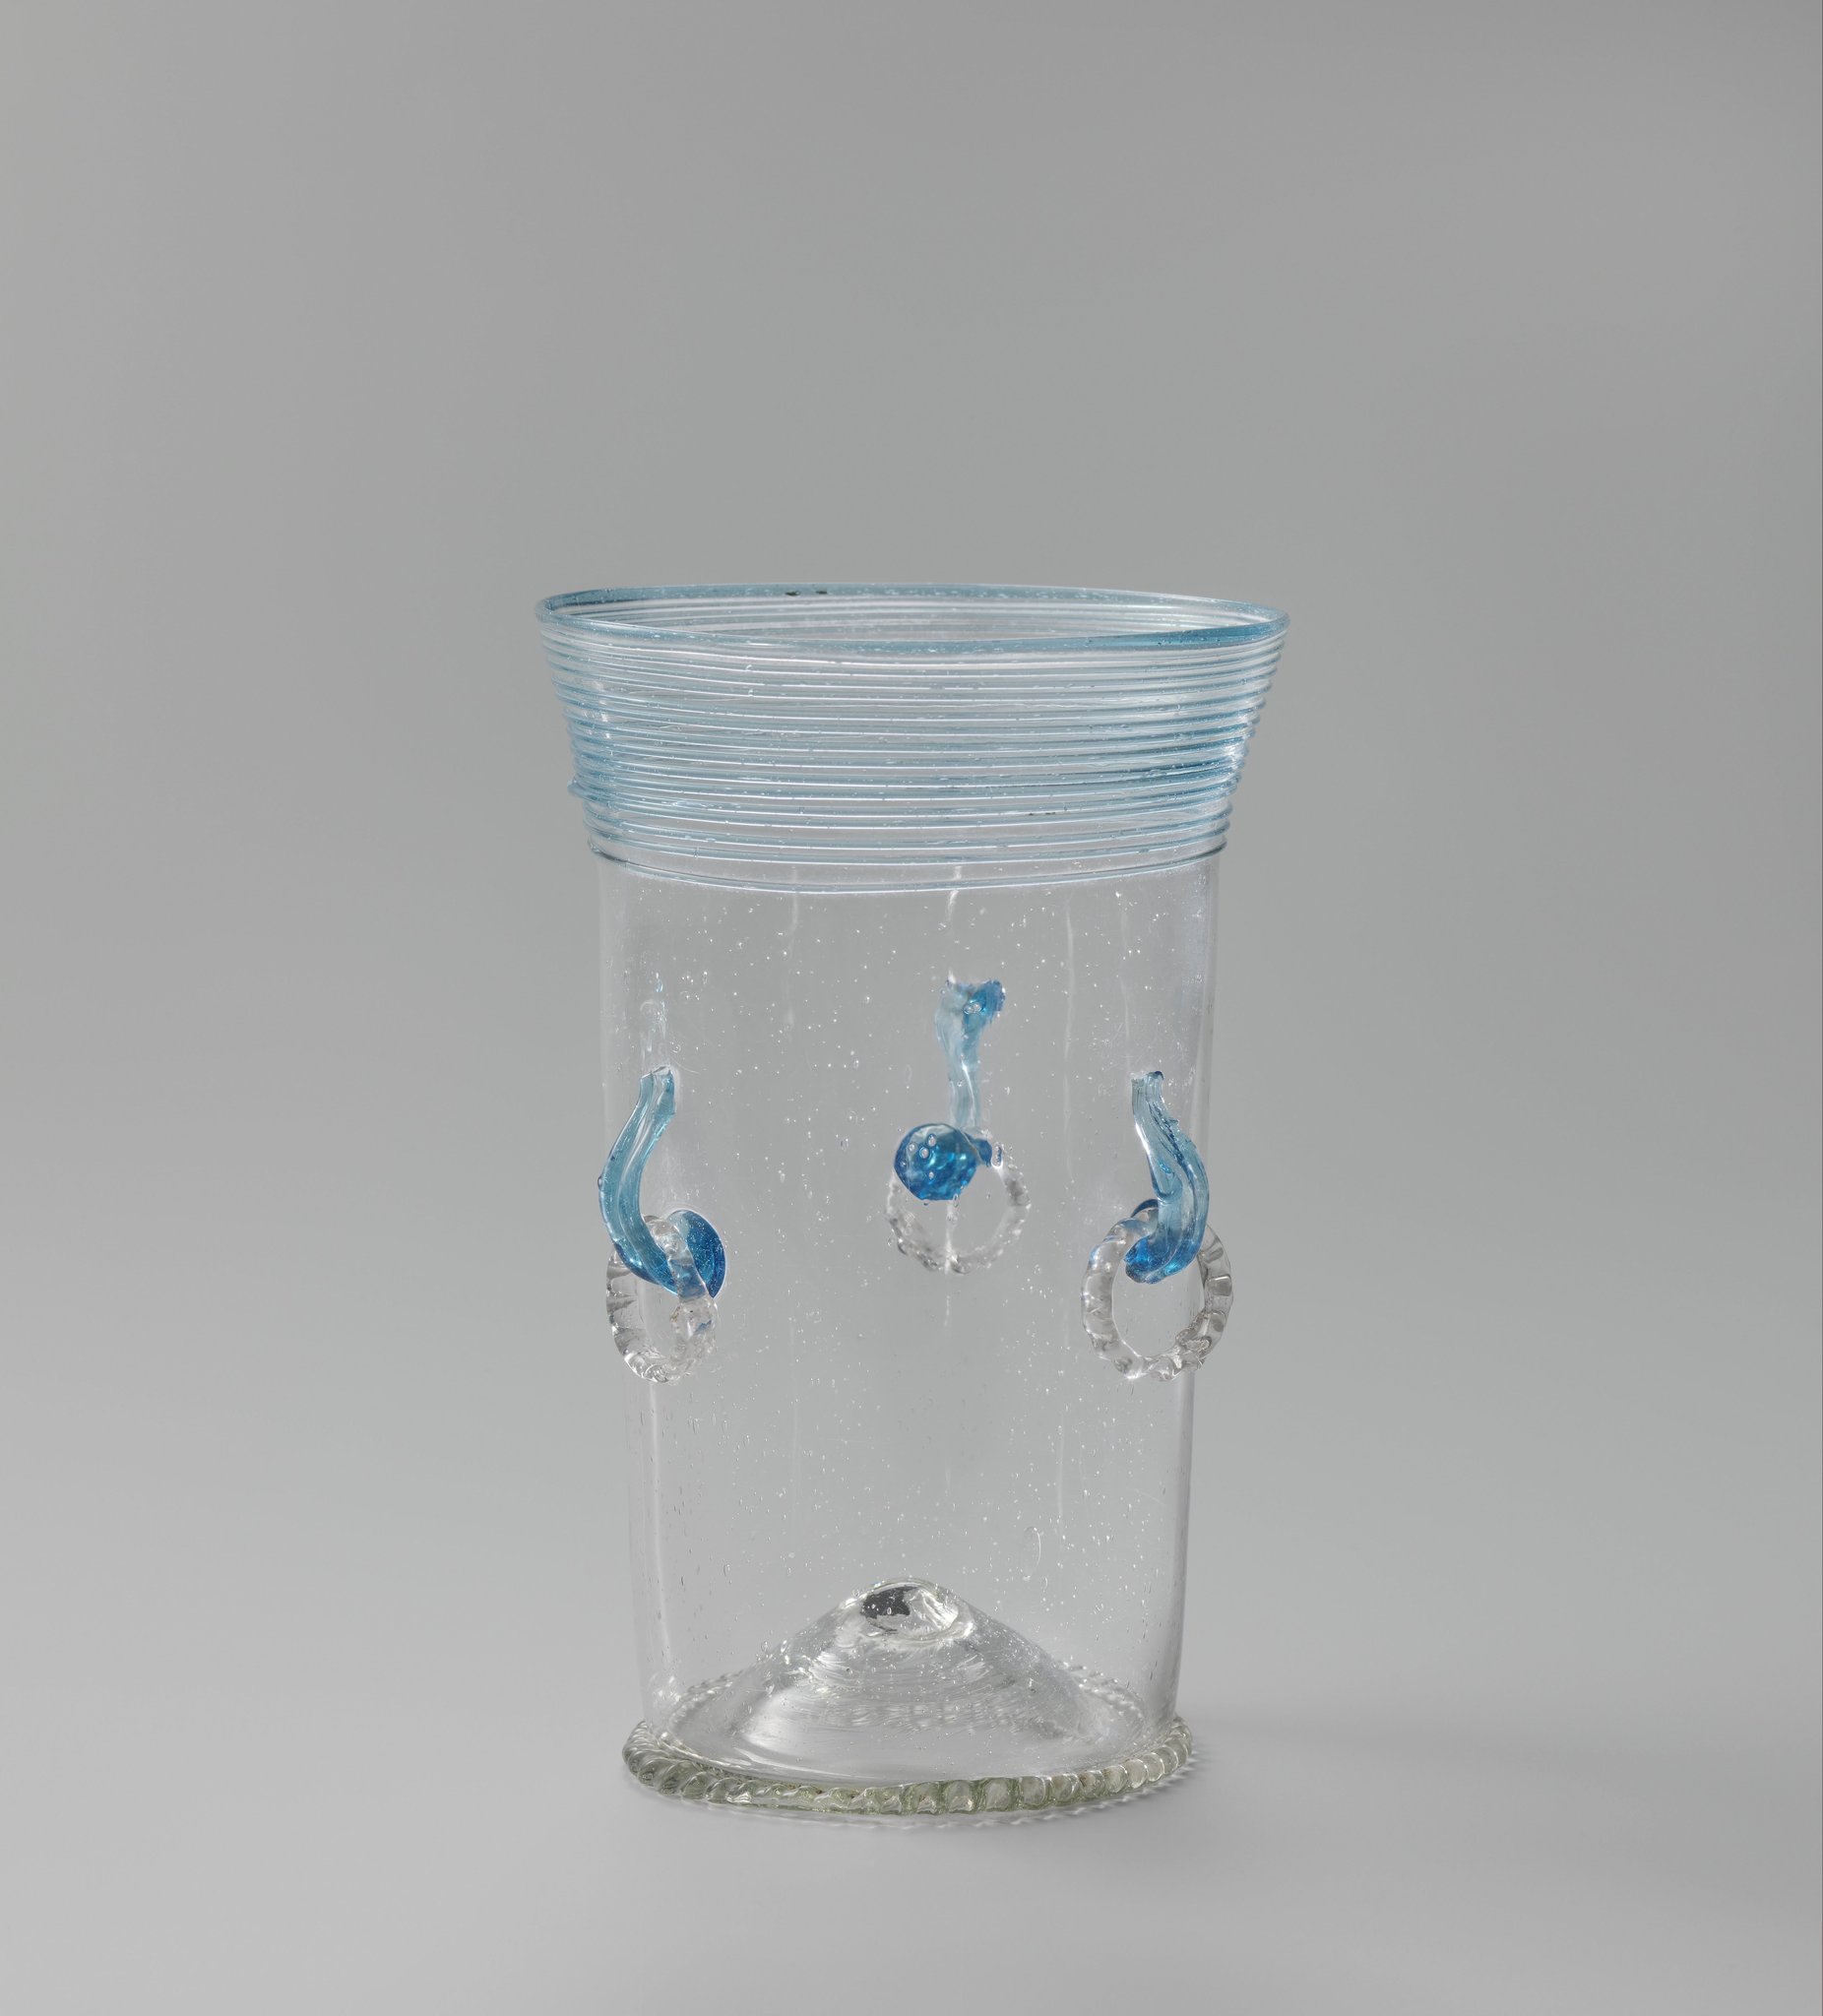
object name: ringbeker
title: Beaker with three loops with pendant rings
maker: Anonymous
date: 1600-1650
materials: glass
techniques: façon de venise, glassblowing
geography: netherlands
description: Glas à la façon de Venise. Ingestoken bodem. Gekerfde voetrand. Cilindrisch, aan de bovenzijde zich verwijdend lichaam, omslingerd met een blauwe draad. Op het lichaam drie blauwe lussen waaraan geribde ringen hangen.